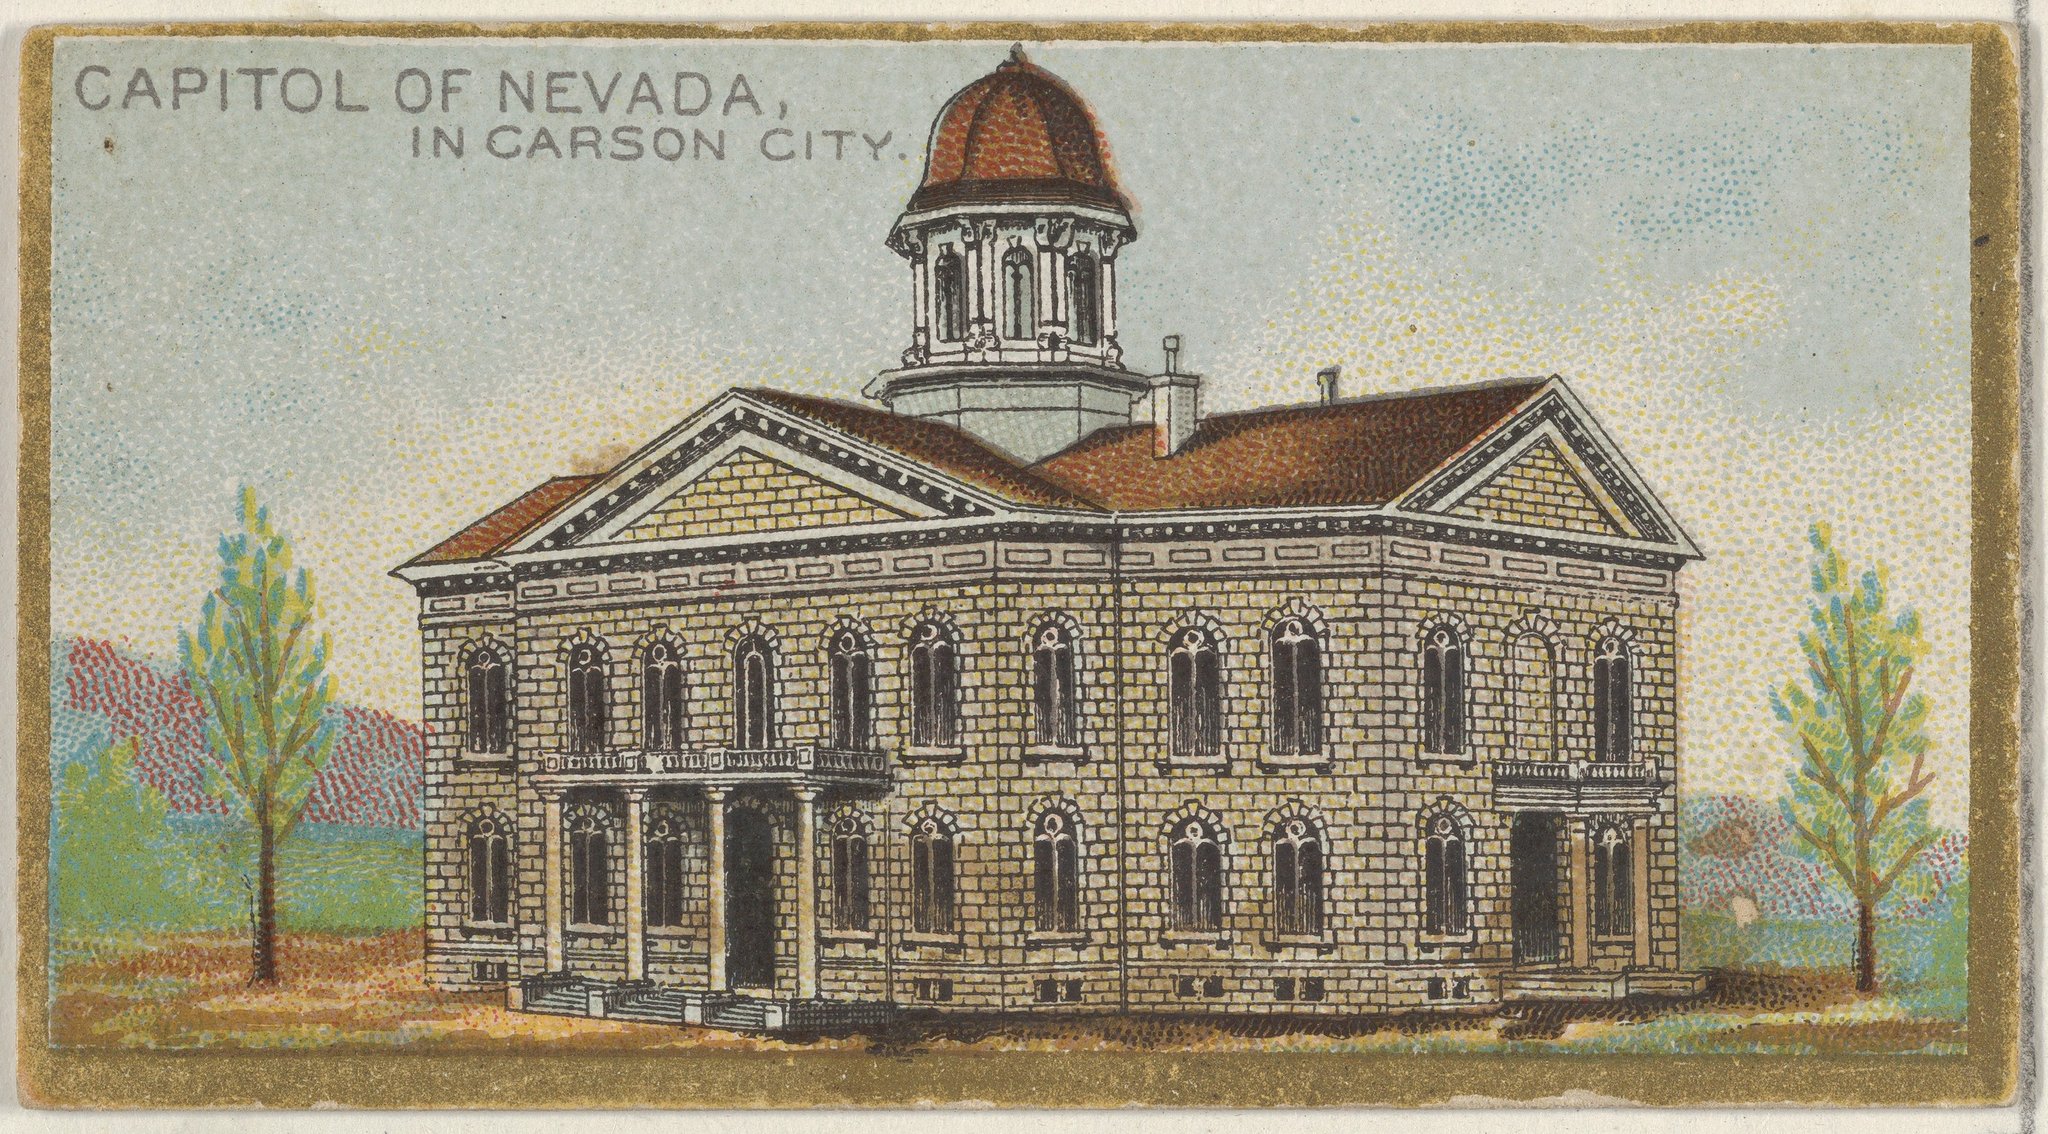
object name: print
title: Capitol of Nevada in Carson City, from the General Government and State Capitol Buildings series (N14) for Allen & Ginter Cigarettes Brands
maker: allen & ginter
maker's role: publisher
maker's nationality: american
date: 1889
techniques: color lithograph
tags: buildings